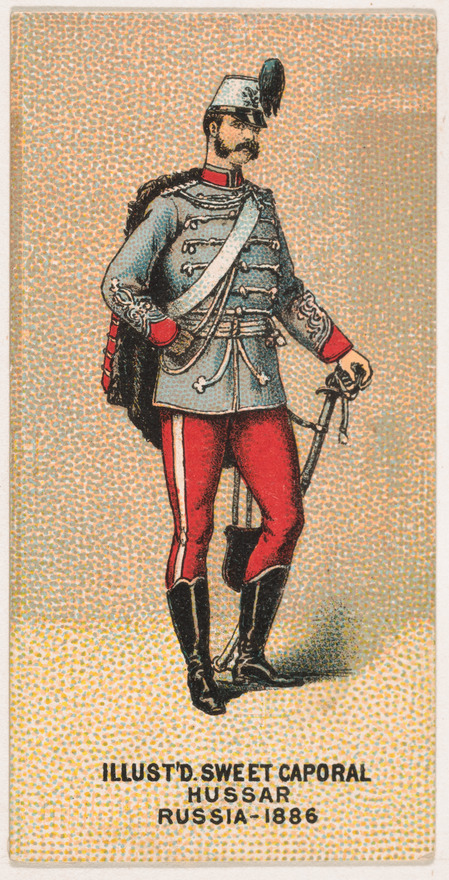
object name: print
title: Hussar, Russia, 1886, from the Military Series (N224) issued by Kinney Tobacco Company to promote Sweet Caporal Cigarettes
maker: kinney brothers tobacco company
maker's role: publisher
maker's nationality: american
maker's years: 1869-2011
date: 1888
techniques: color lithograph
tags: military,men